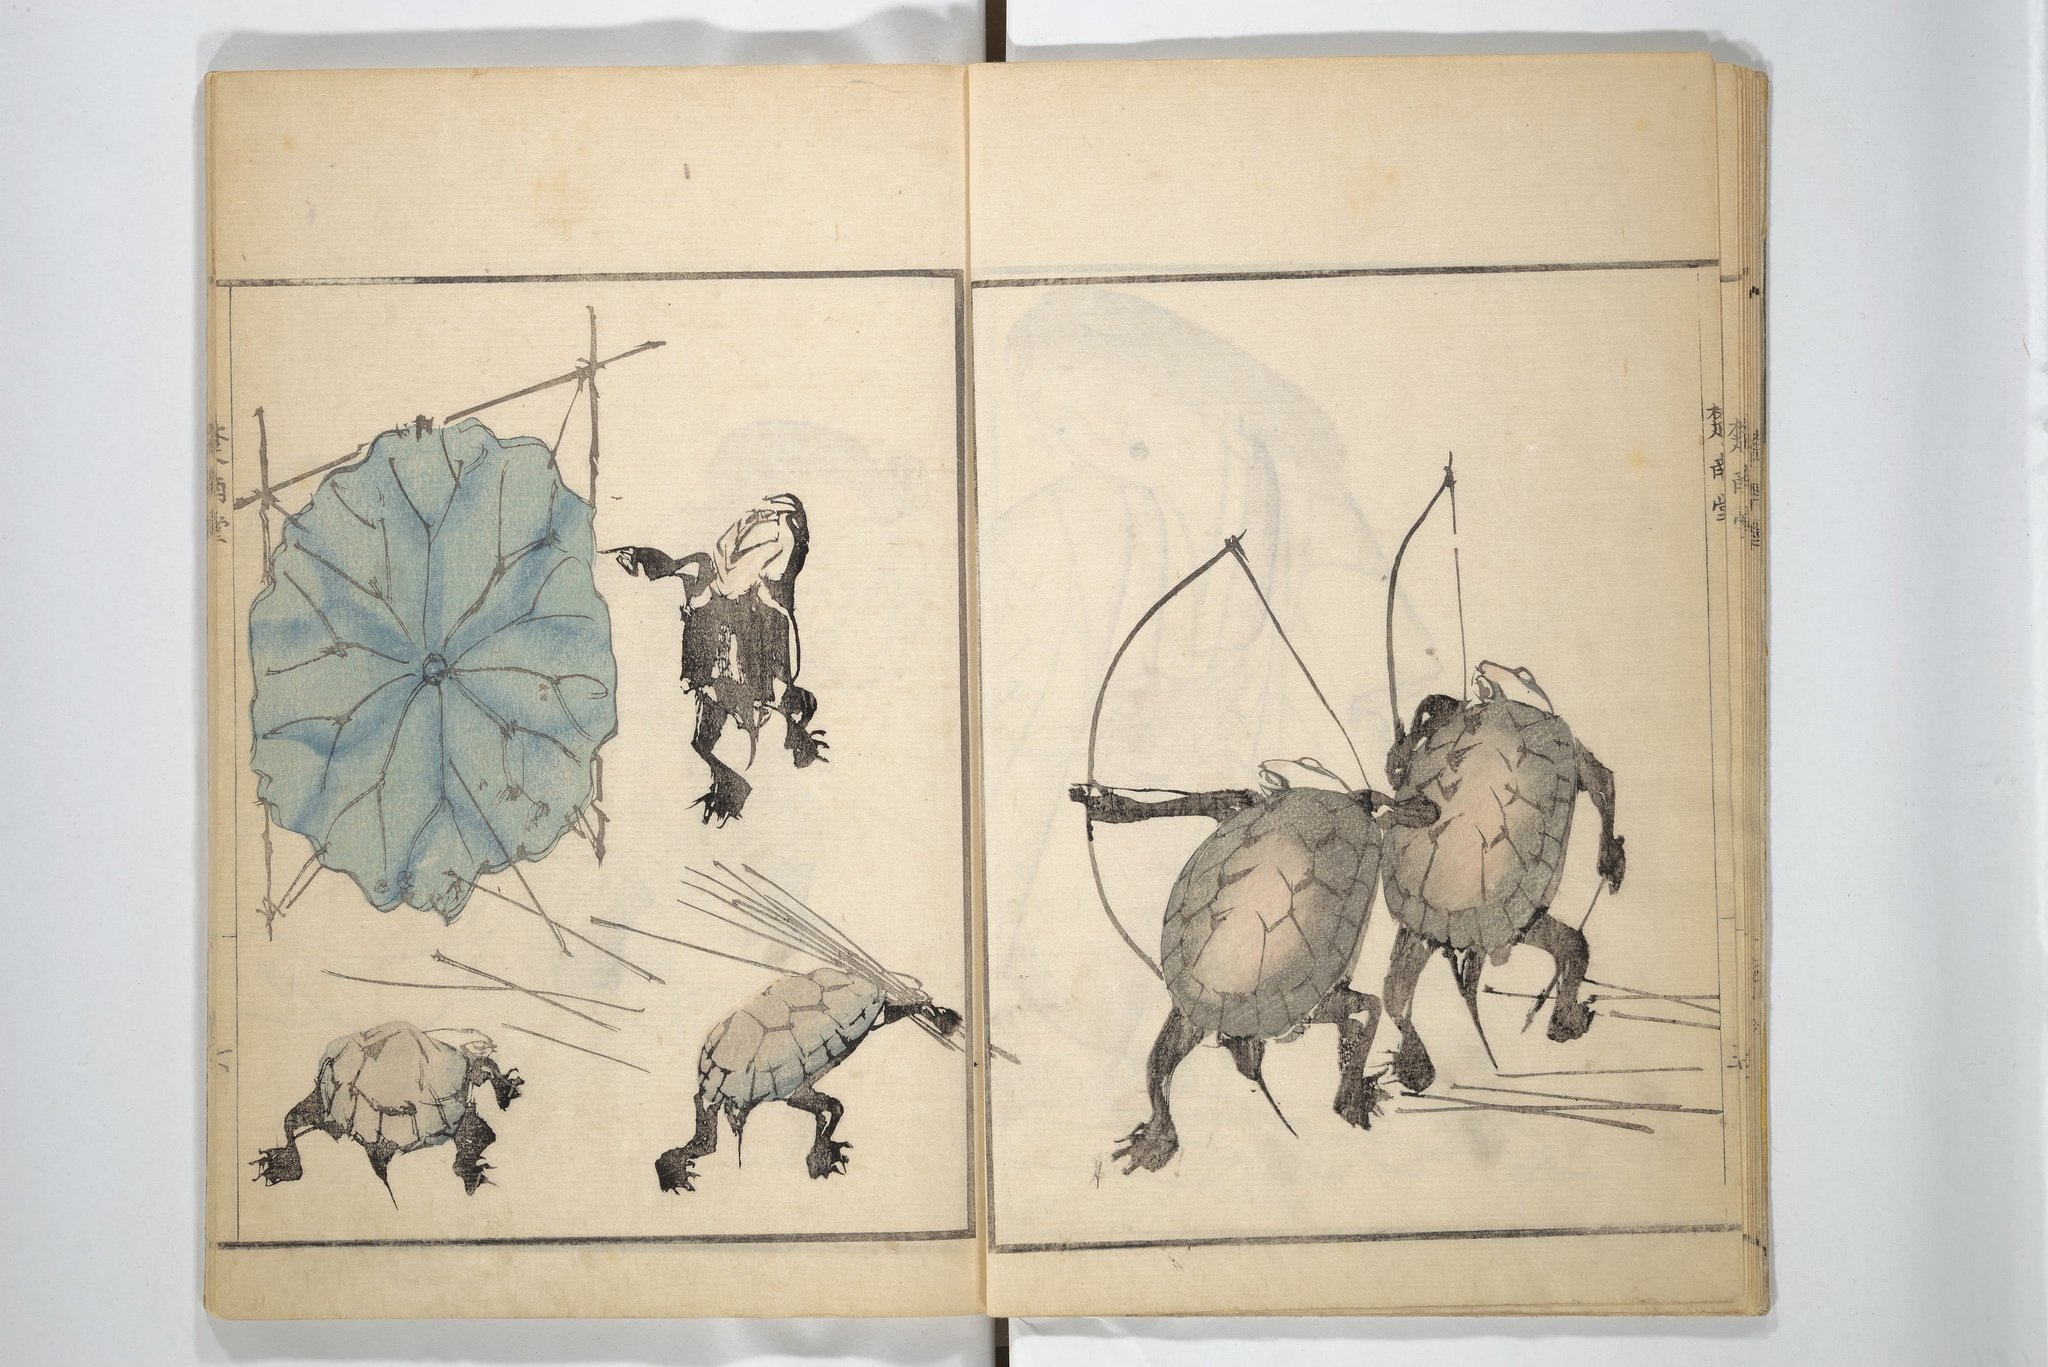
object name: illustrated book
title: Sōnan (Chinnen) Picture Album (Sōnan gafu) 楚南画譜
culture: japanese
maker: onishi chinnen 大西椿年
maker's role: artist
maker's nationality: japanese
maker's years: 1792-1851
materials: ink, paper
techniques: woodblock print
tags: birds,bow and arrow,men,women,turtles,flowers